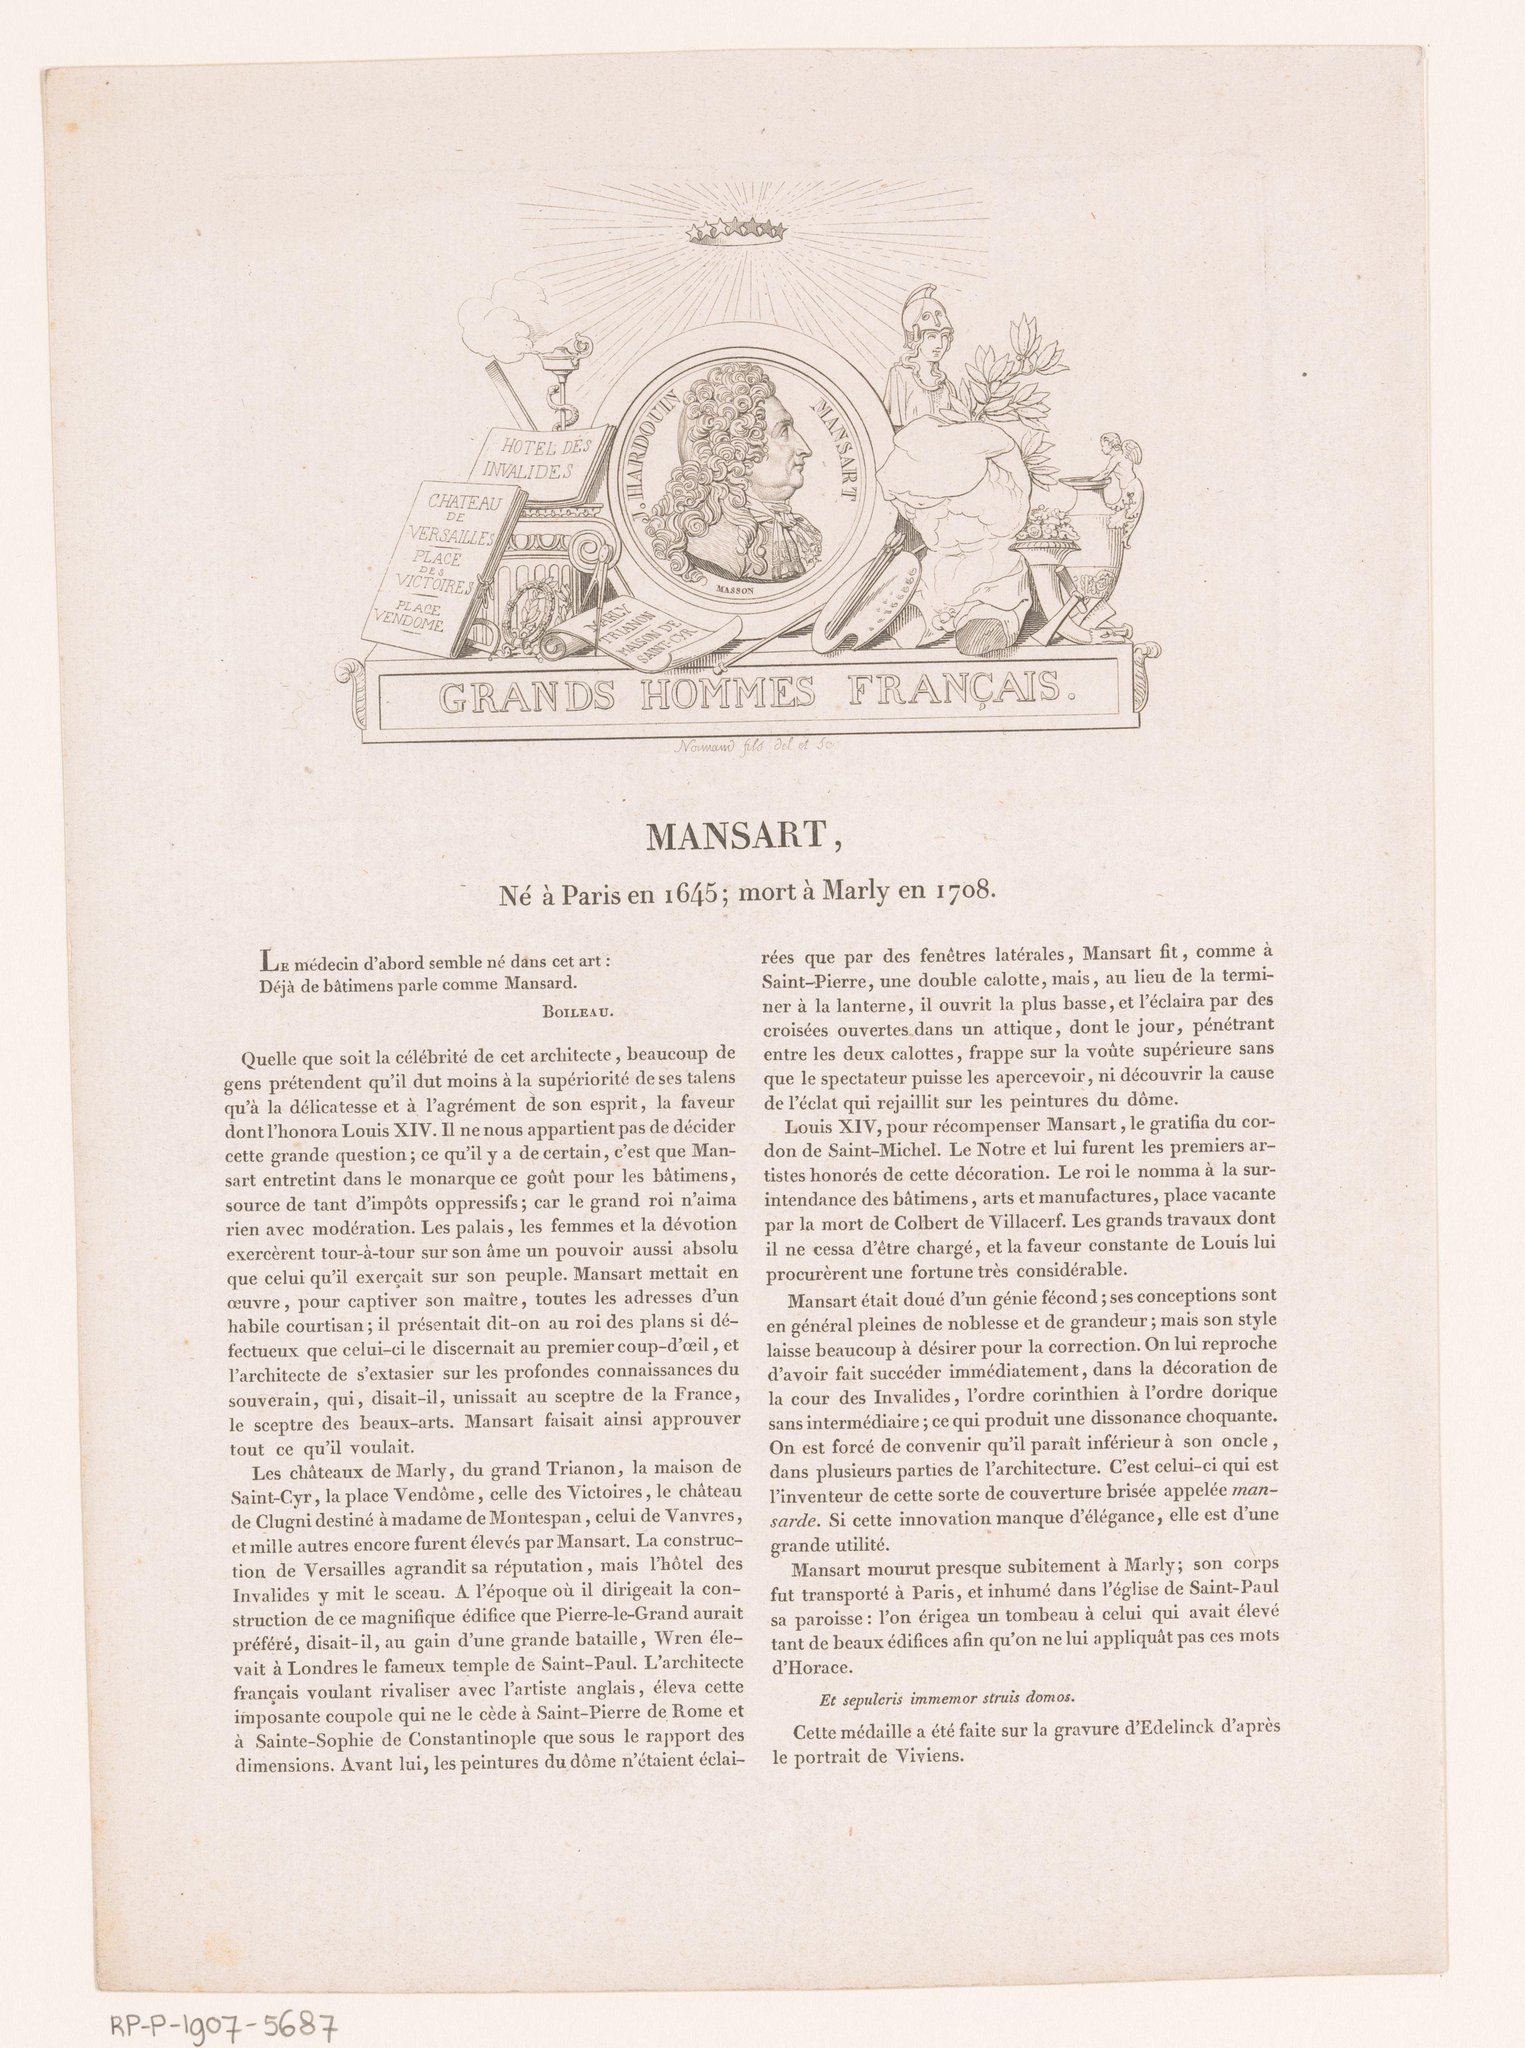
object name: print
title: Portret van Jules Hardouin-Mansart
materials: paper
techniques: etching, letterpress printing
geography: paris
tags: historical persons, portrait, self-portrait of architect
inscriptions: collector's mark: Lugt 2228